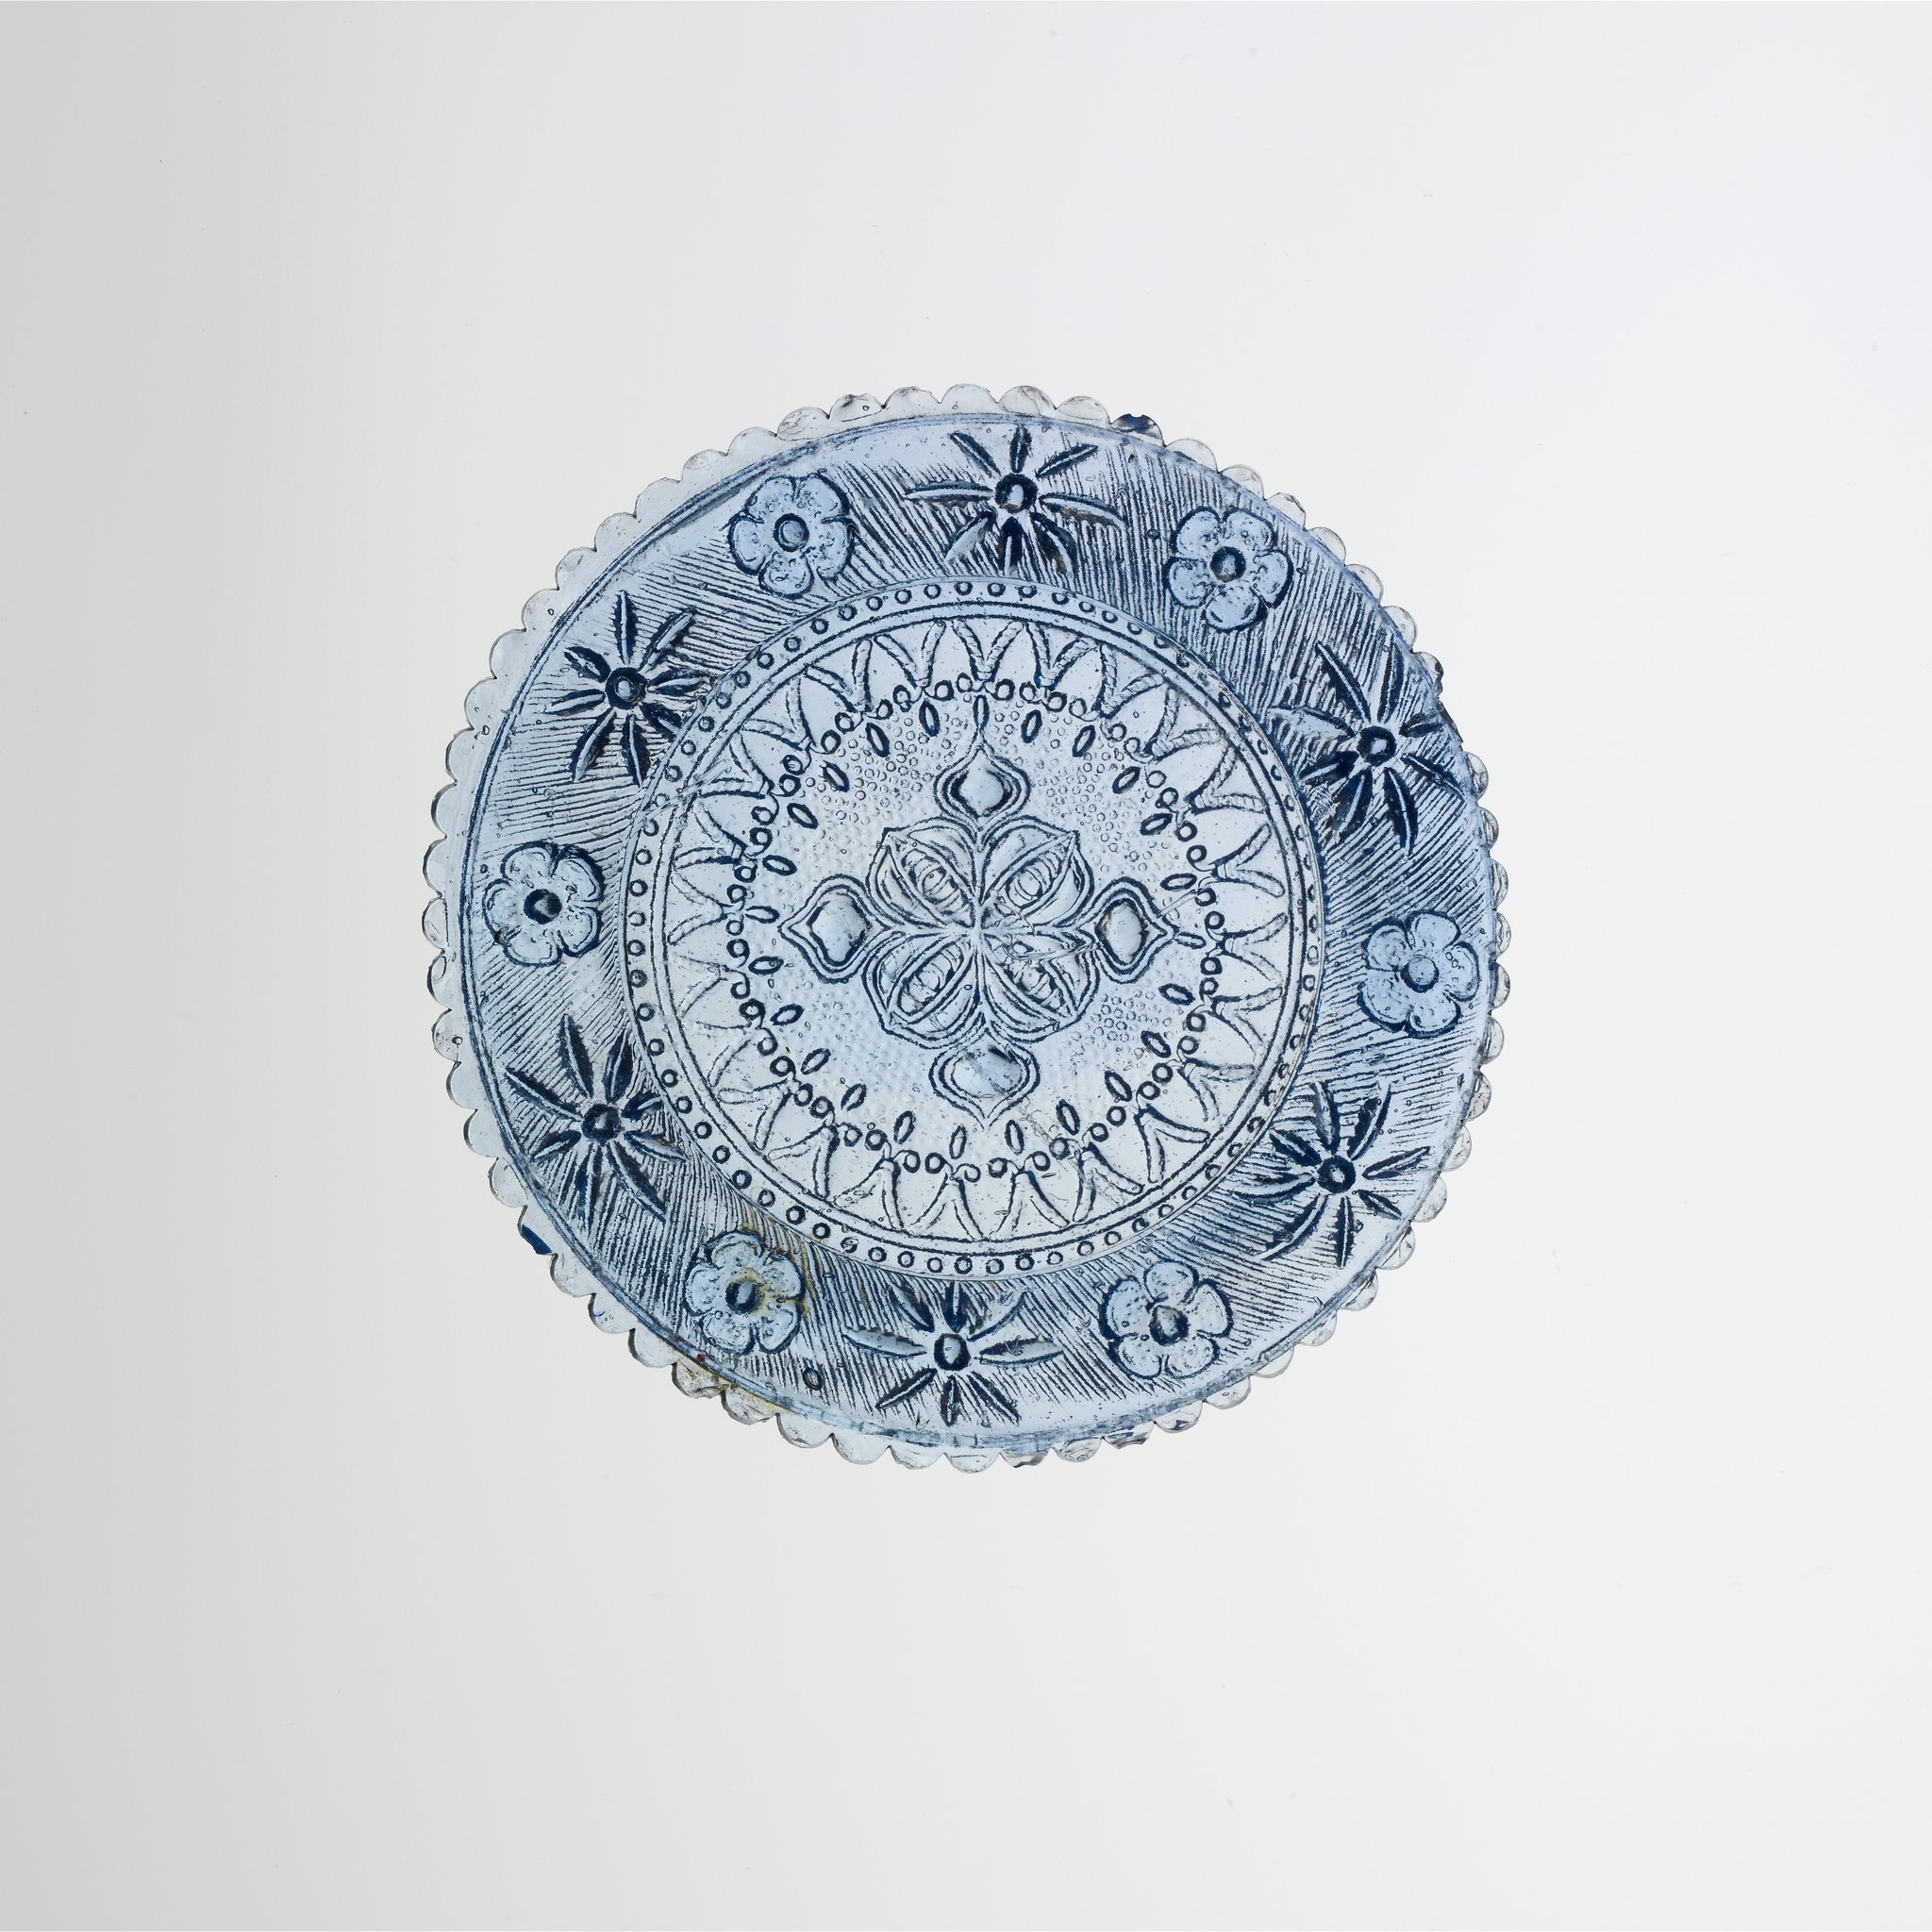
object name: cup plate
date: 1825-1860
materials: glass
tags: flowers